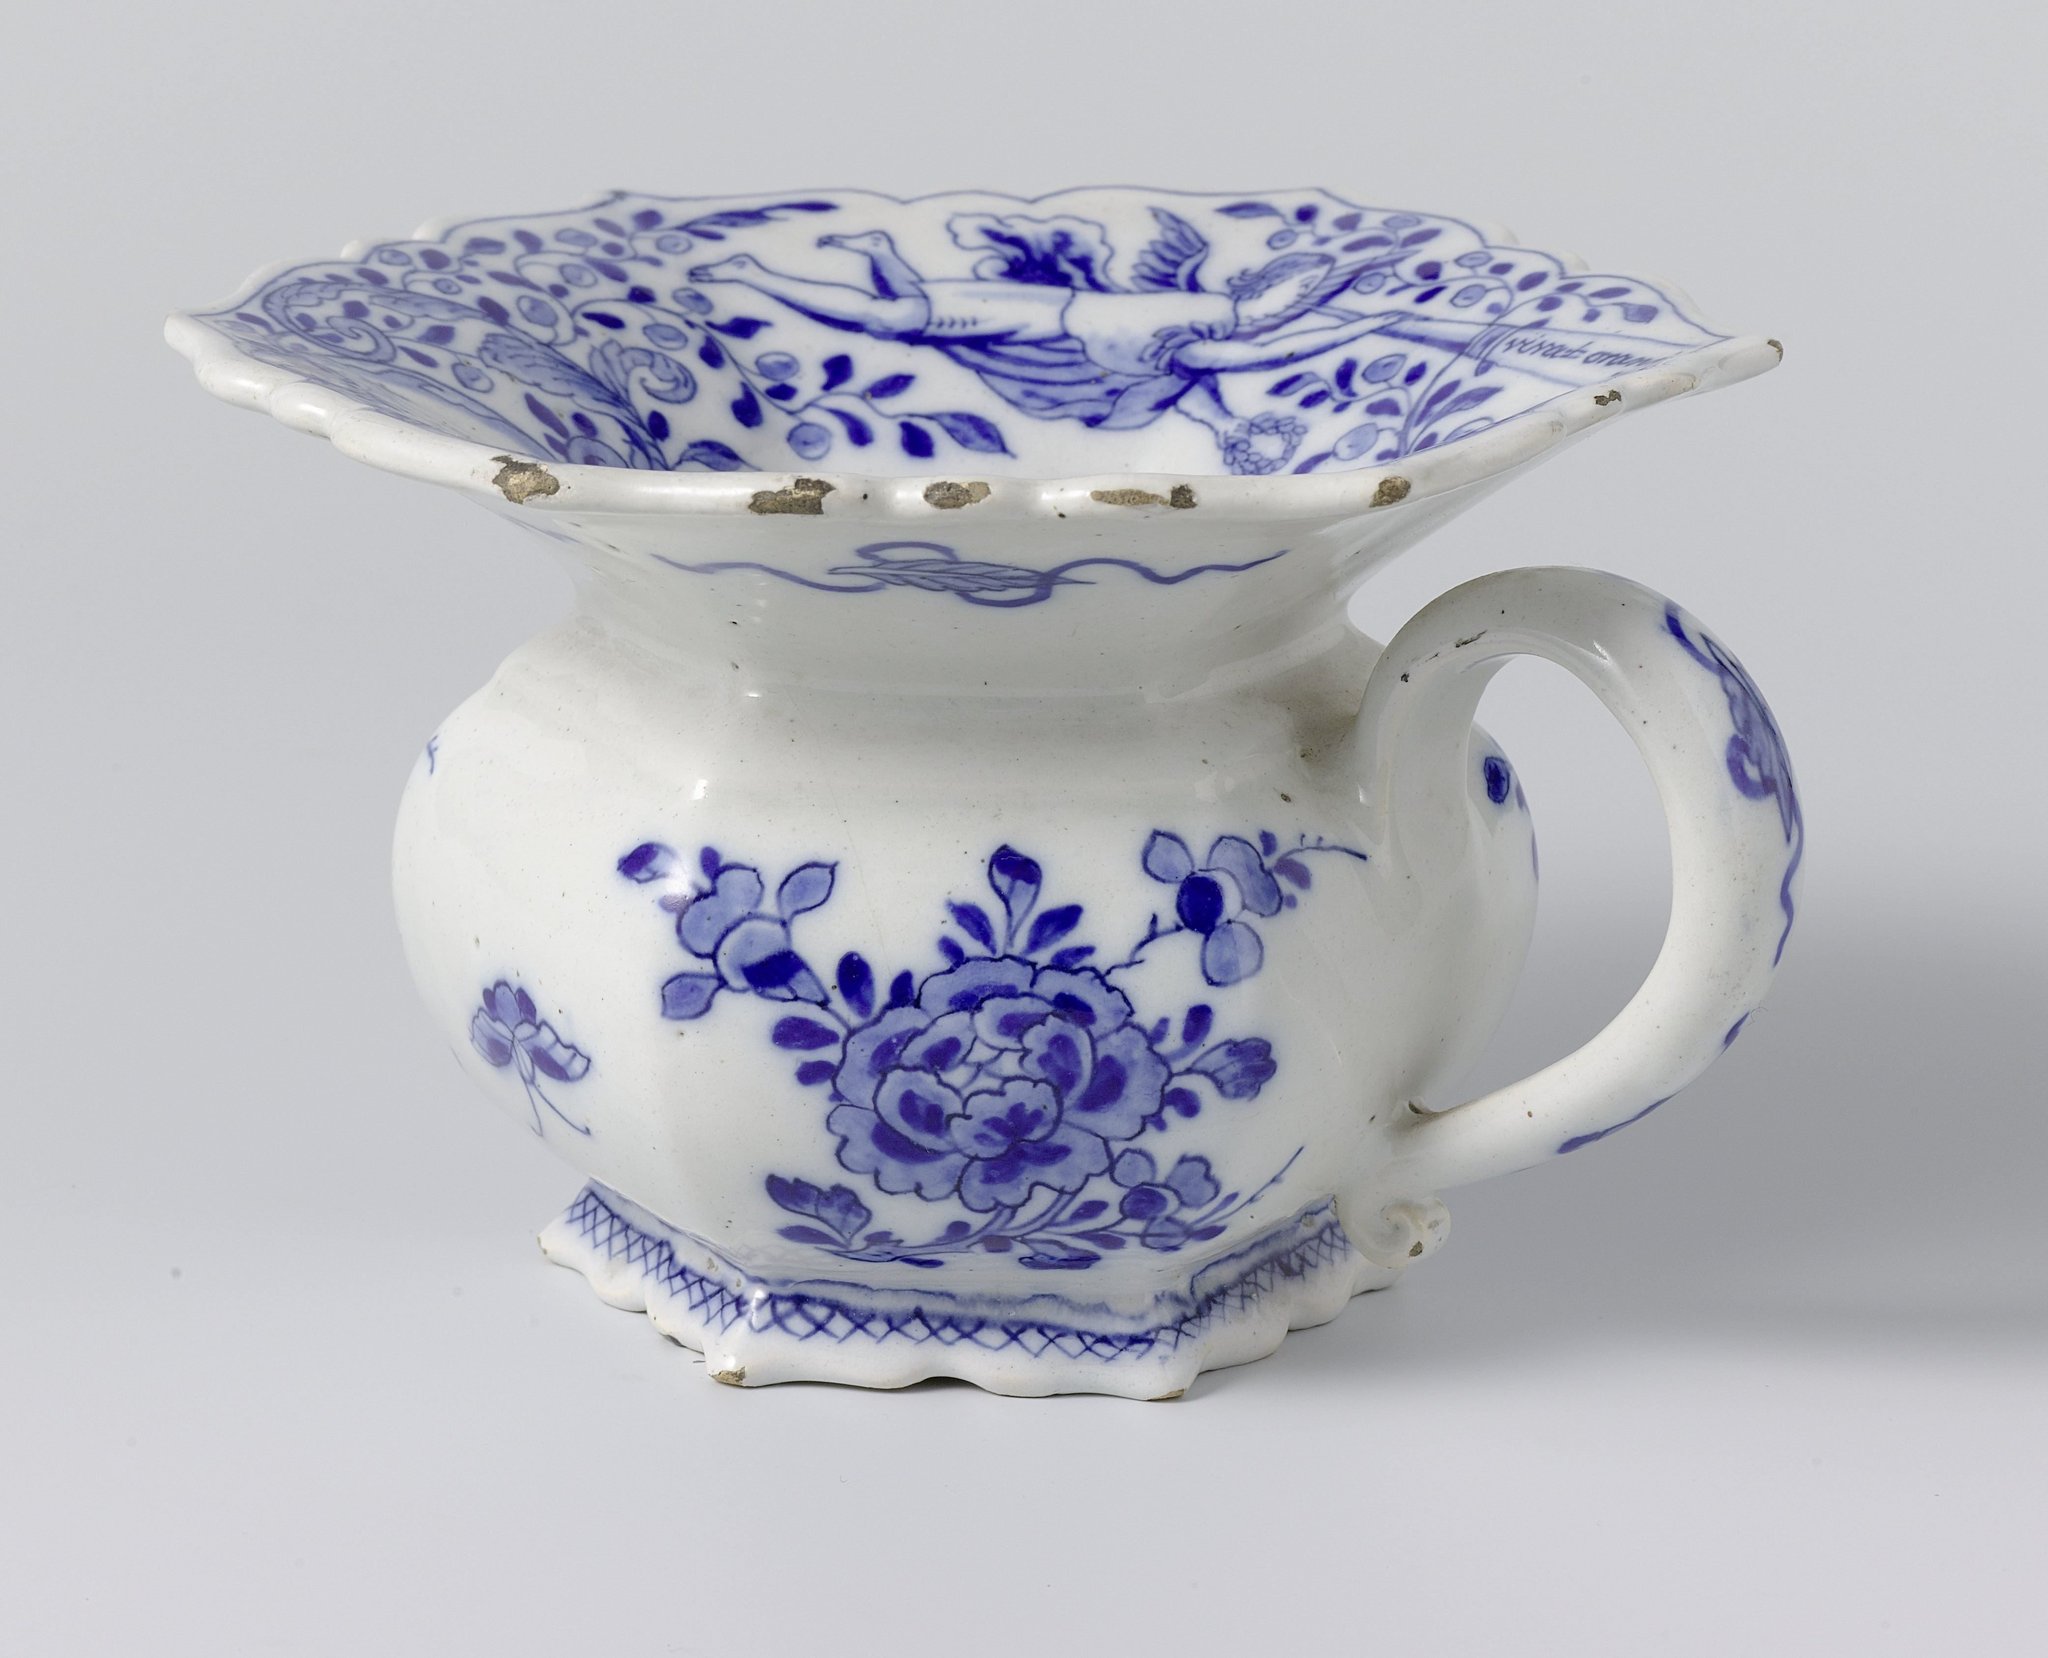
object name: spittoon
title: Kwispedoor met voorstelling van Willem IV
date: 1747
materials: earthenware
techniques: firing, painted, vitrification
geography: delft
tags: the hague, willem iv (prins van oranje-nassau)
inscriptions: inscription: ‘vivat oranje’, date: ‘Ao 1747’, inscription: ‘W:C:H:F/ Uijtgeroepen/ tot stadhouder/ den 3 in bloeijmaant’, mark: ‘D/ 62’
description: Kwispedoor met bolle zeskantige buik en enigszins schuinopstaande, uitgeschulpte, brede zeskantige rand, terwijl de lage voet ook zeskantig is en even uitgeschulpt. Versierd in onderglazuur blauw, met op de voet een ruitjespatroon, op de buik drie pioenrozen en twee vlinders, op de rand rechts portret van een man (Willem IV), borstbeeld in profiel naar links, de Orde van de Kousenband dragend, in cartouche met blauwe achtergrond. Opschrift: W:C:H:F Uijtgeroepen tot Stadhouder den 3 bloeijmaant Ao 1747.